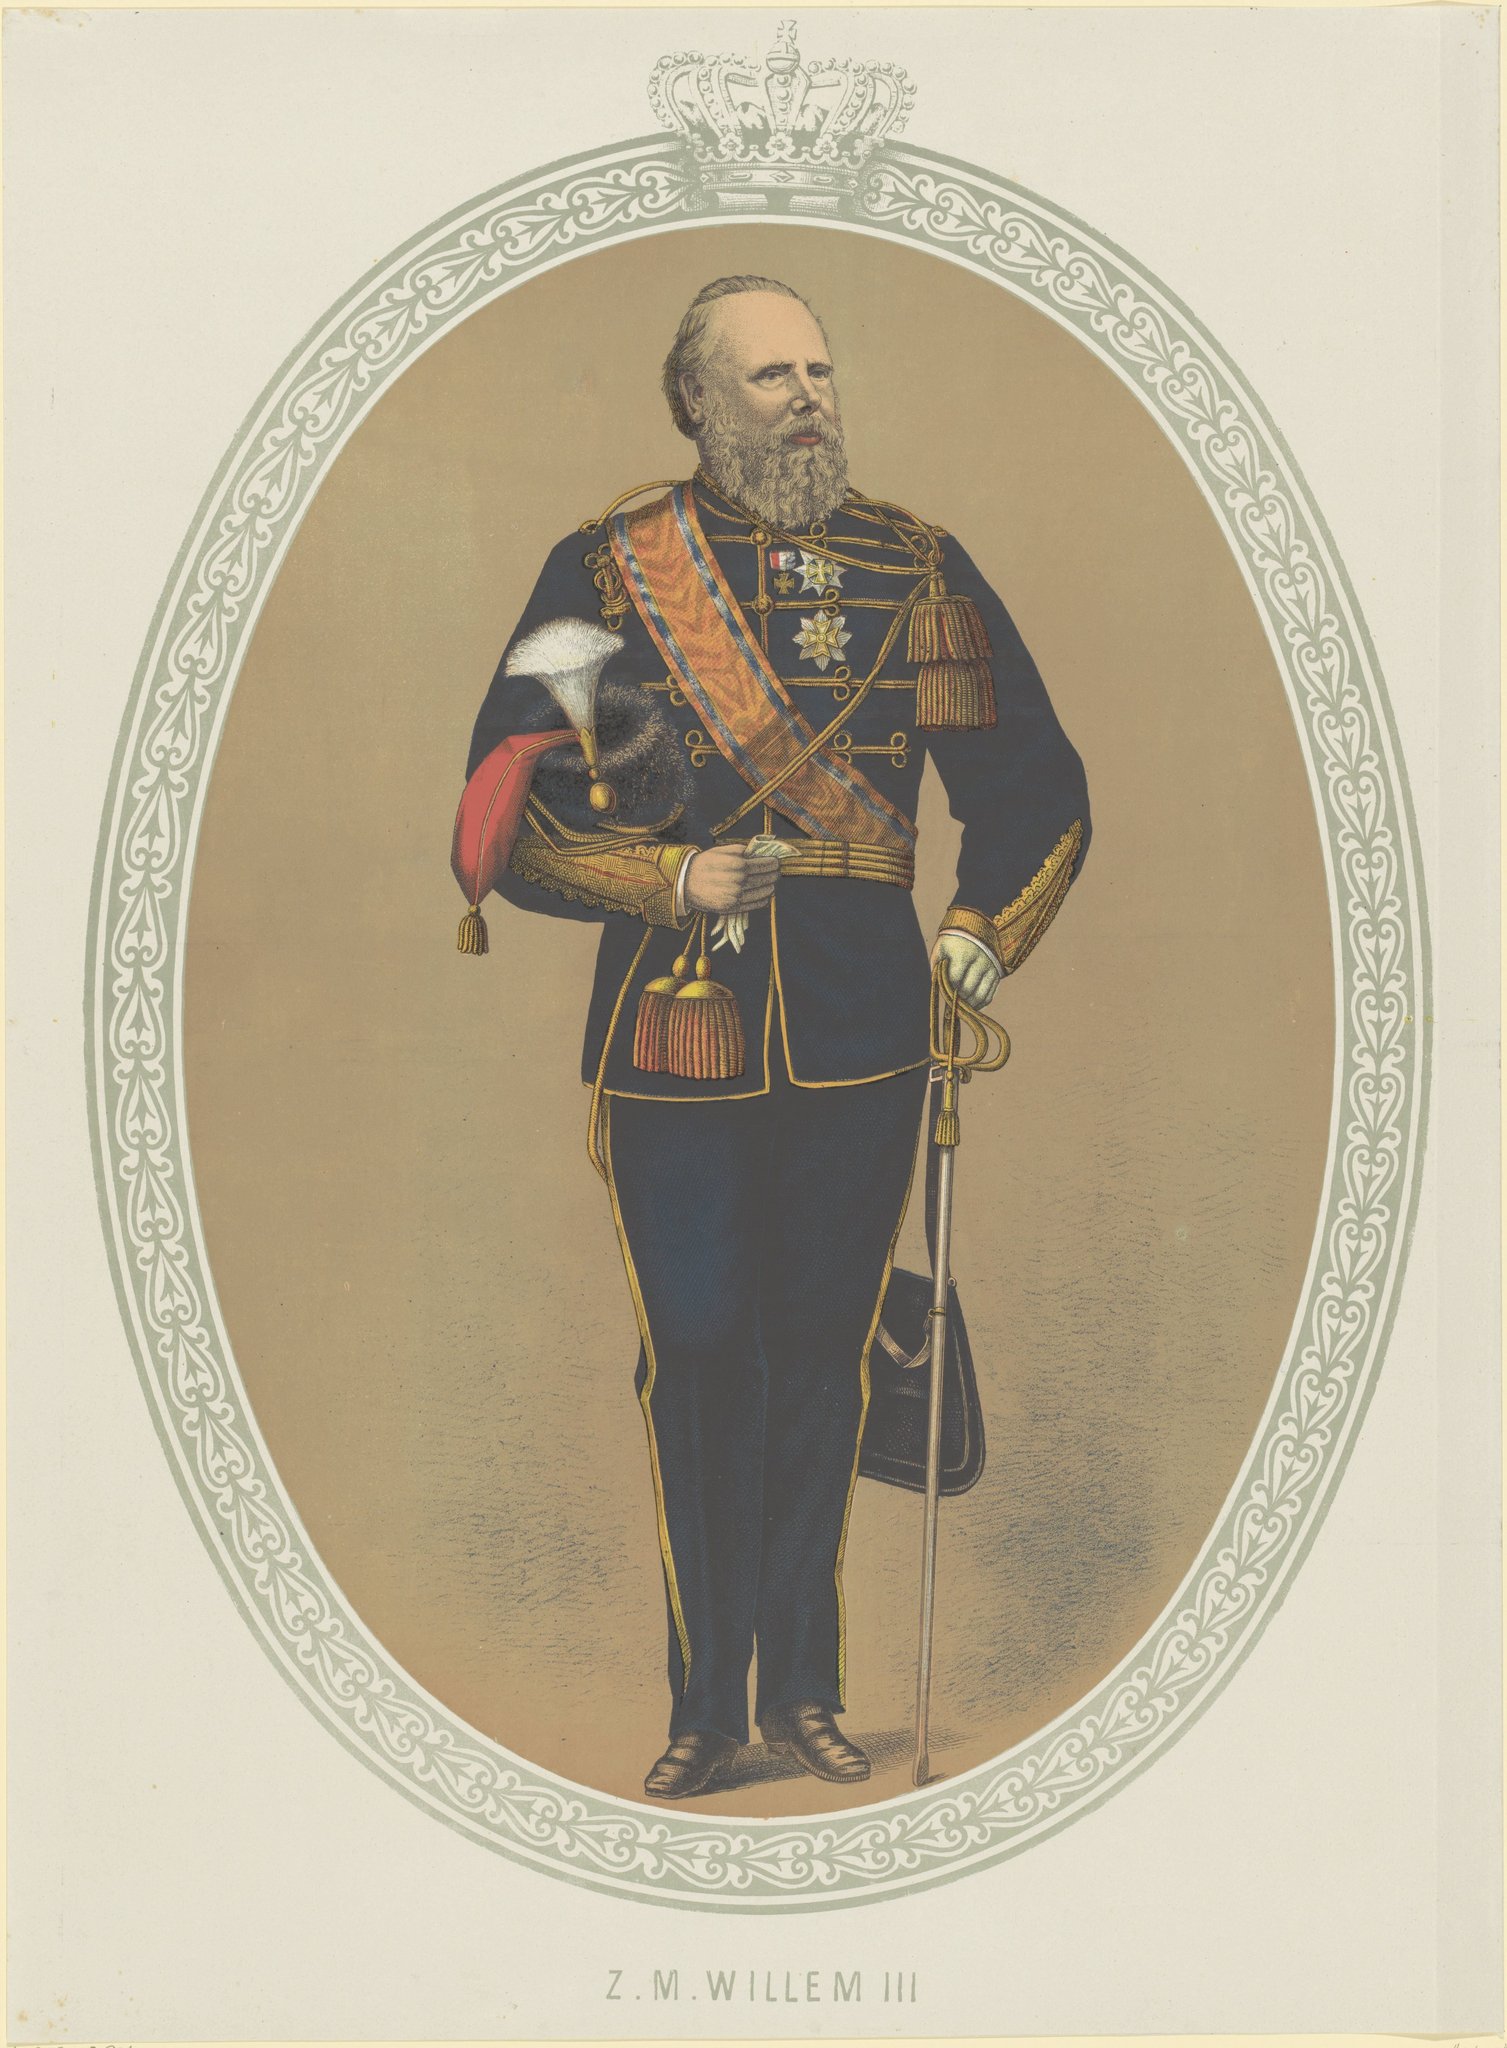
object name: print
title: Portret van Willem III, koning der Nederlanden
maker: Anonymous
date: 1849-1899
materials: paper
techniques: lithograph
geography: netherlands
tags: willem iii (koning der nederlanden)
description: De hier vermelde titel verwijst naar de hoogst verkregen titel van de geportretteerde, niet per se naar de titel die de geportretteerde op deze voorstelling draagt.